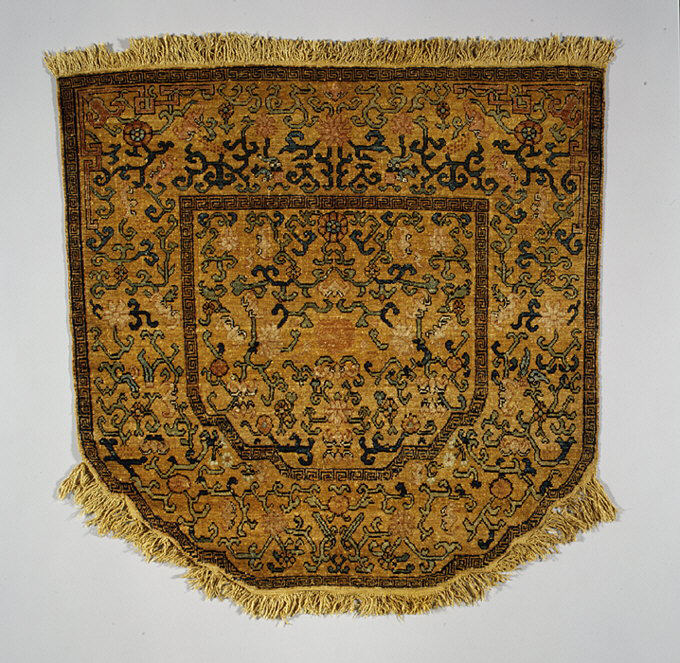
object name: rug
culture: chinese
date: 1801-1900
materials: cotton, silk